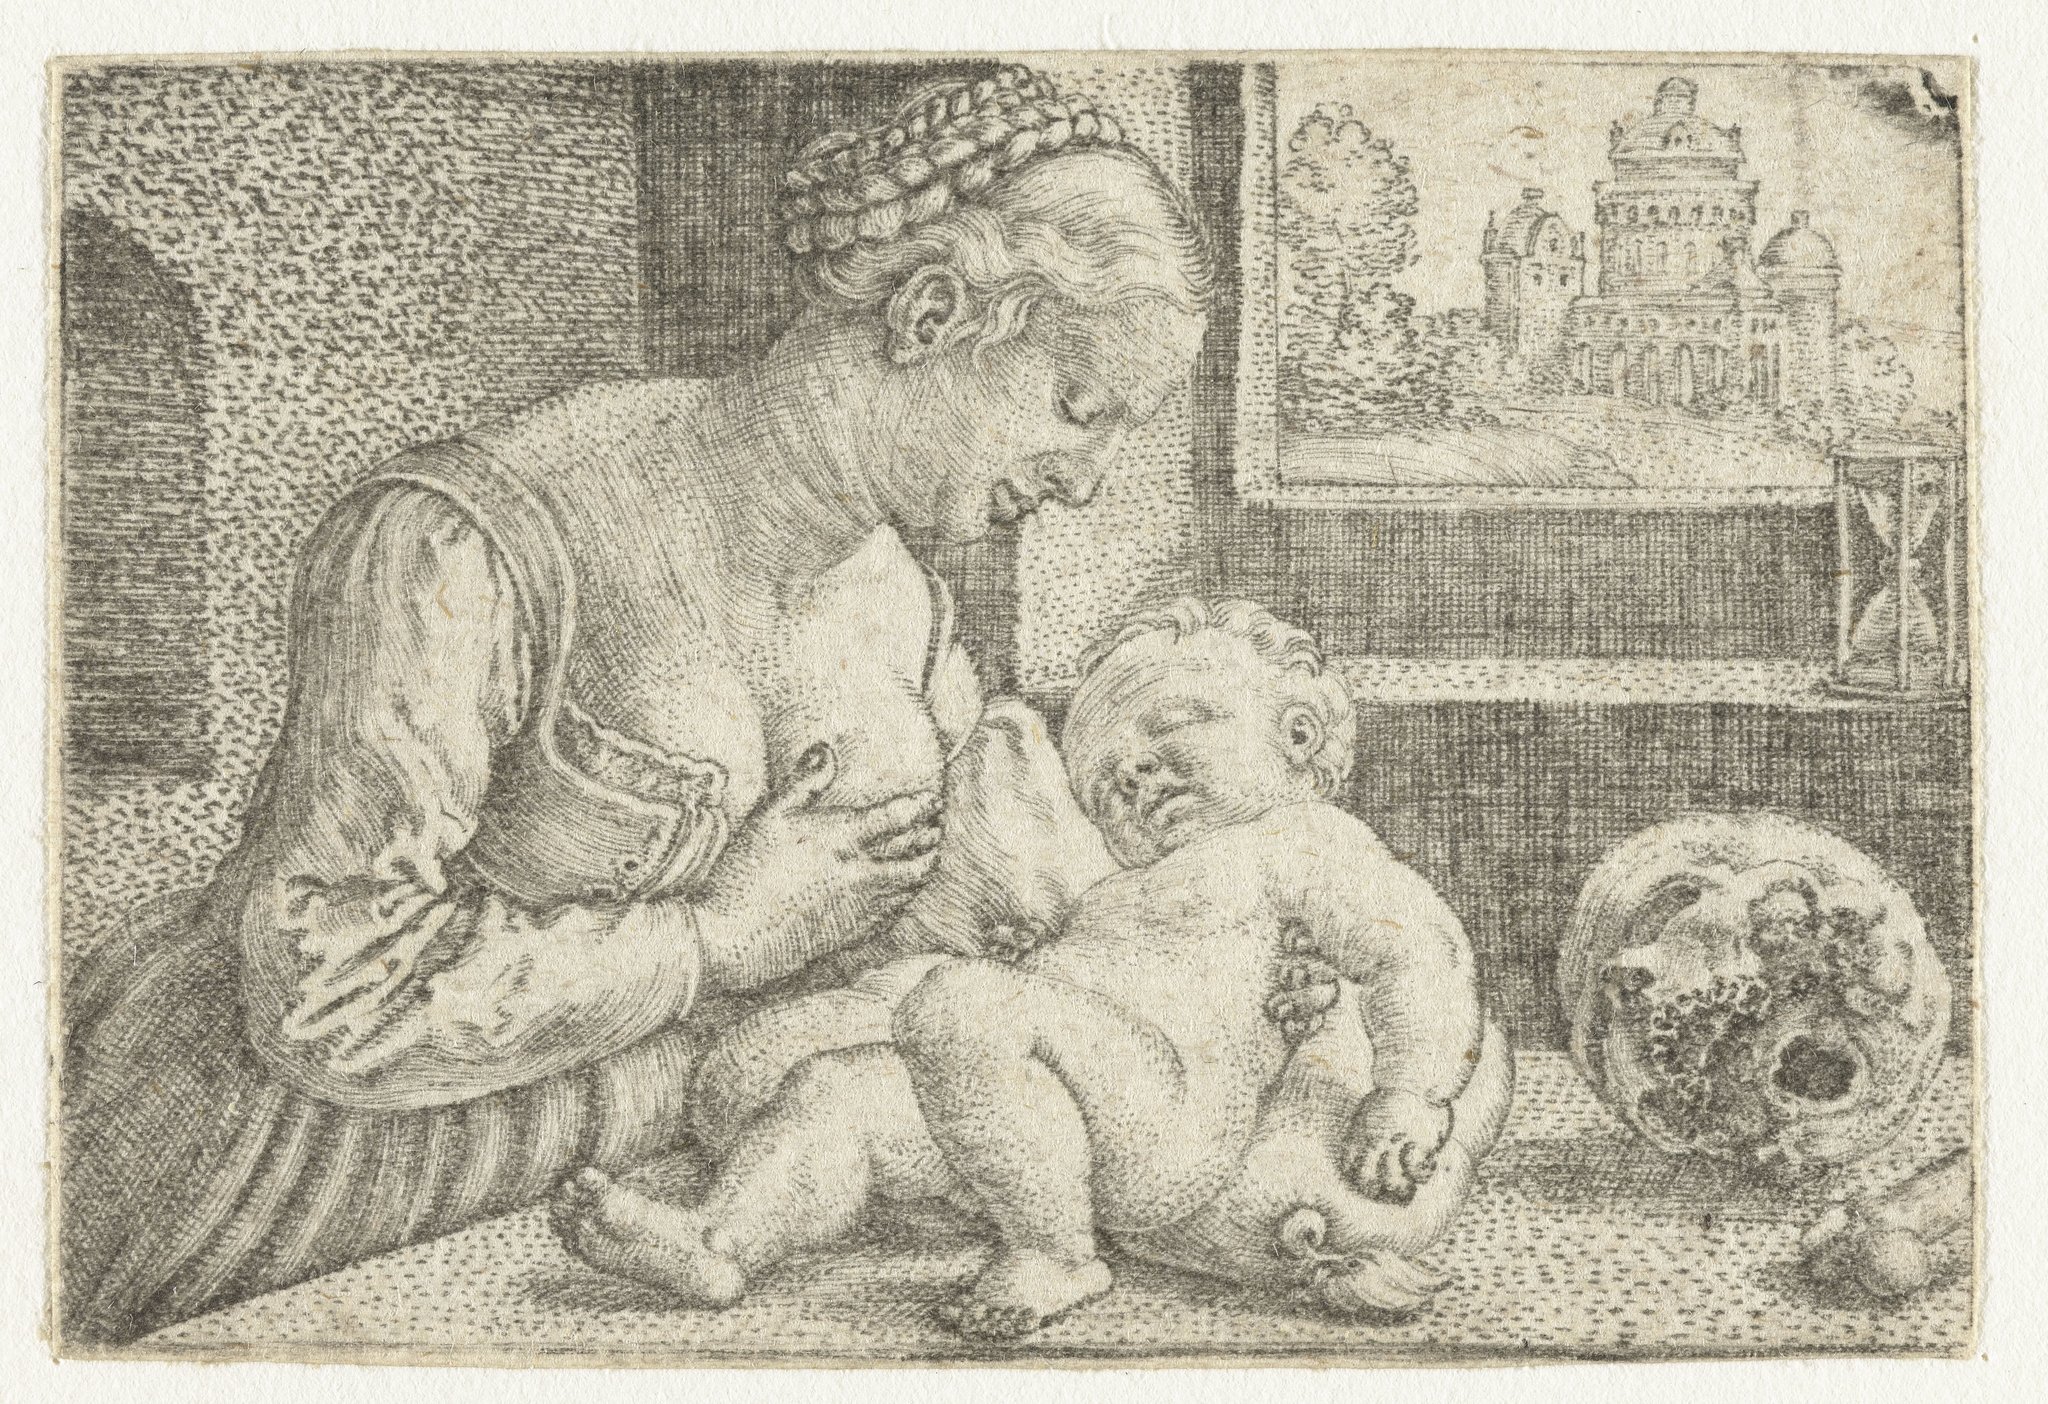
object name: print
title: Maria met kind aan borst en schedel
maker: barthel beham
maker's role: print maker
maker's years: 1502-1540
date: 1512-1540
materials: paper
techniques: engraving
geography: germany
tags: christ-child suckling, or beginning to suckle, e.g. mary uncovering her breast ~ madonna-representations, skull as symbol of 'vanitas', hourglass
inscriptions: collector's mark: Lugt 2166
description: Maria is weergegeven als een jonge moeder die haar kind de borst geeft. Twee vanitas symbolen contrasteren met dit jonge leven: optafel ligt een schedel en voor het raam met een vergezicht staat een zandloper.